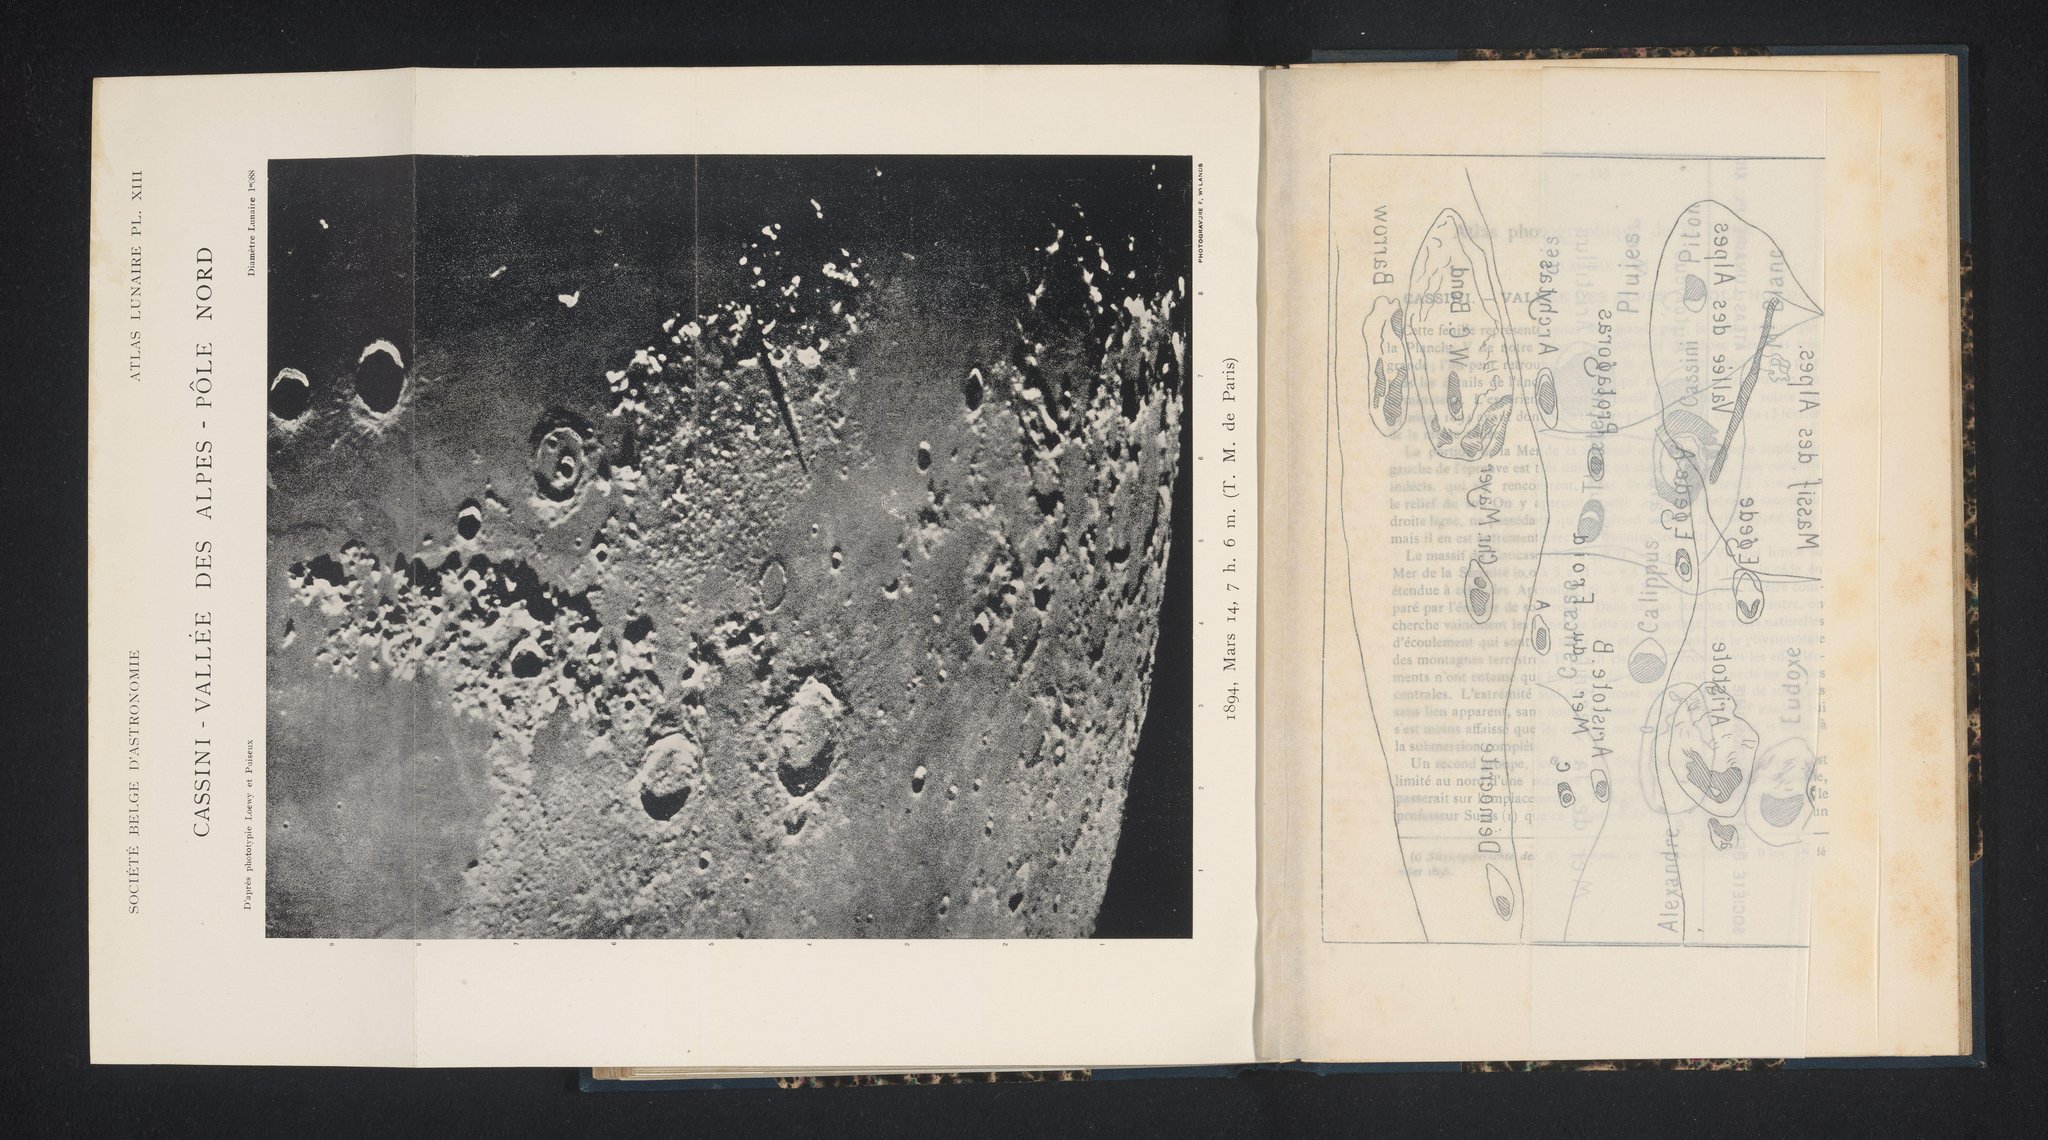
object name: photomechanical print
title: Cassini - Valée des Alpes - Pôle nord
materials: paper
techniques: autotype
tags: surface of the moon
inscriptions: inscription: ‘Société Belge D'Astronomie Atlas Lunaire Pl. XIII/ 1894, Mars 14, 7 h. 6m. (T. M. de Paris)’